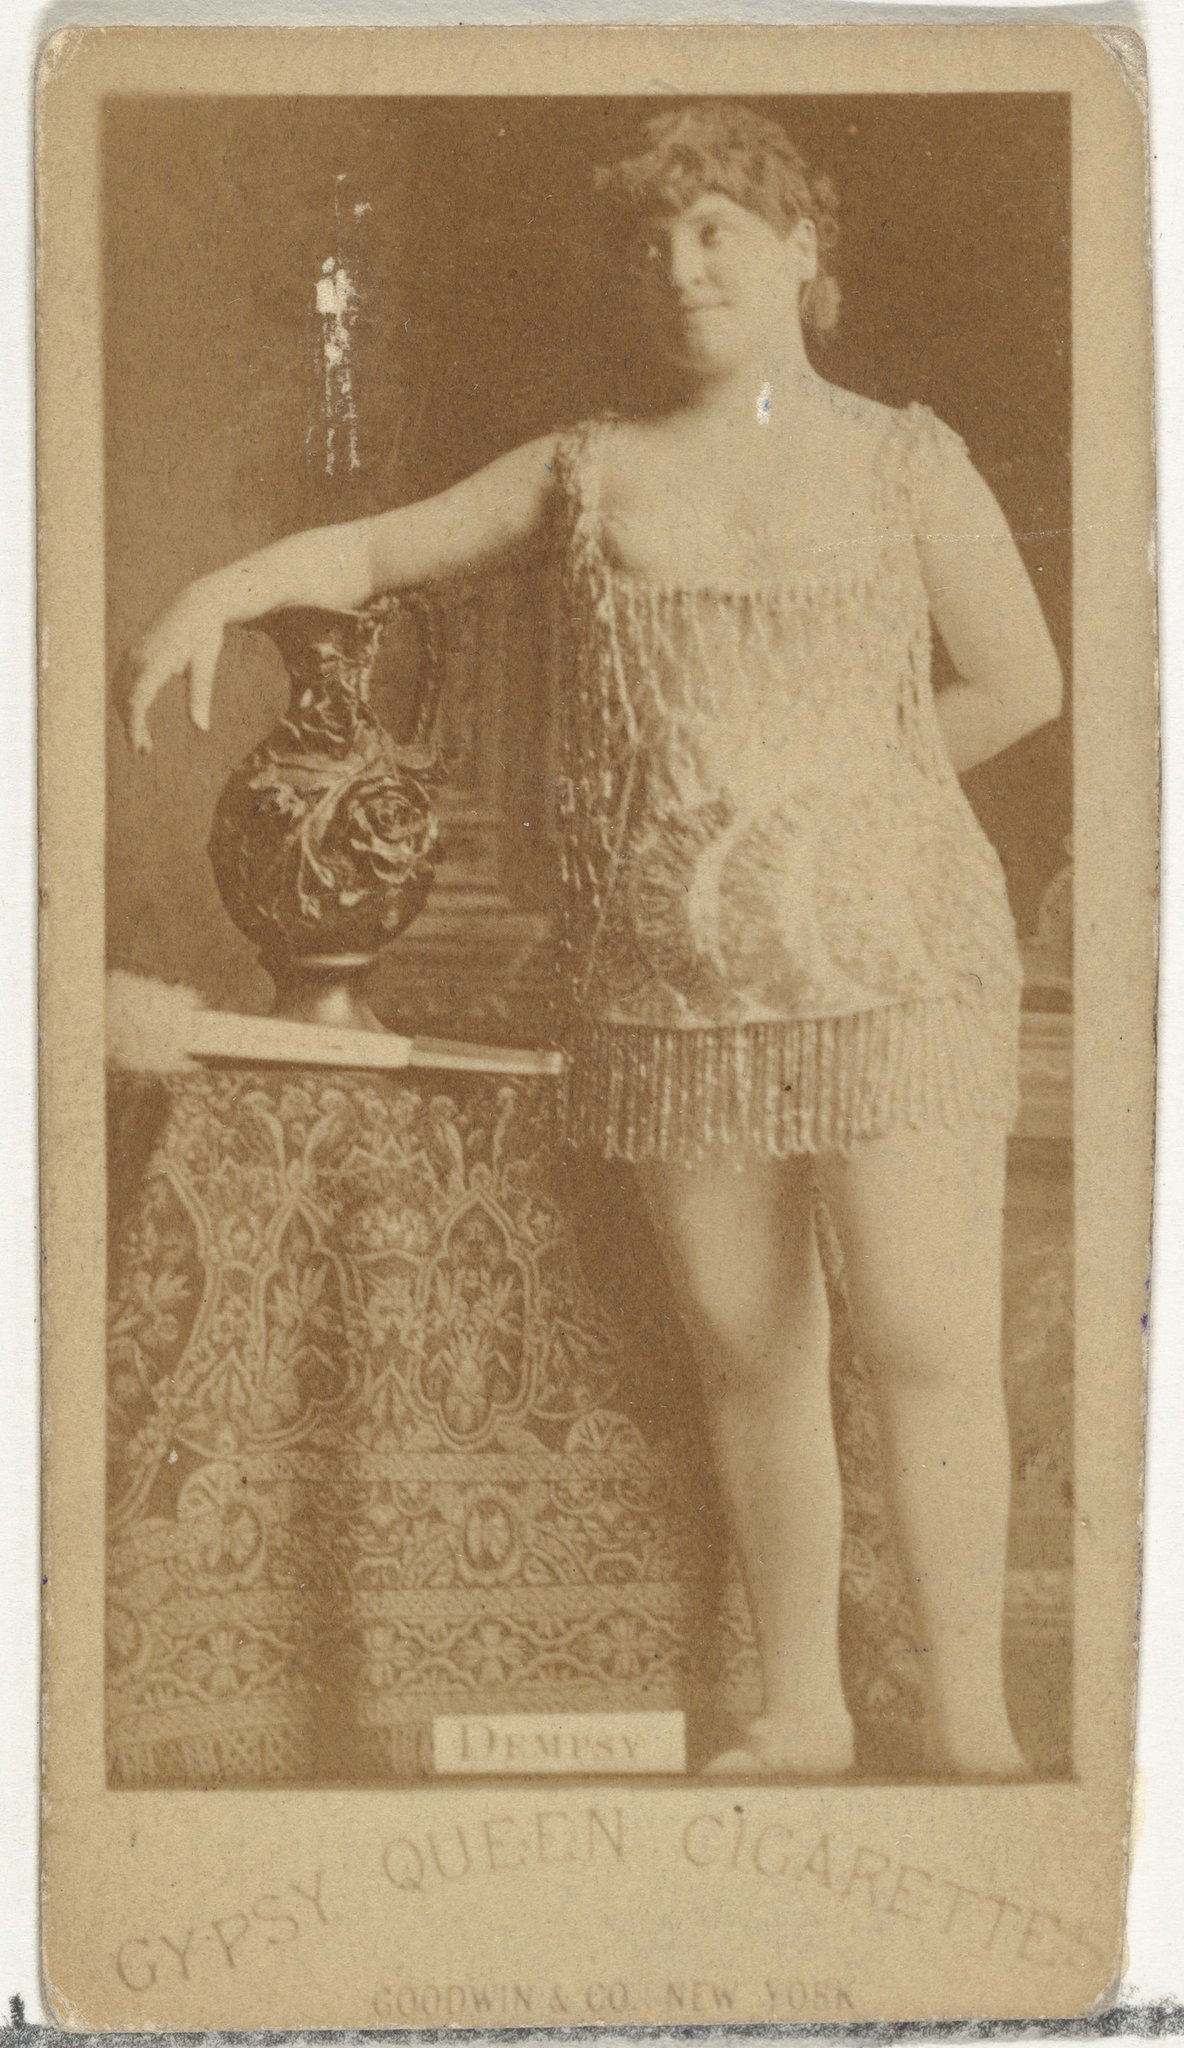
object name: photograph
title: Dempsy, from the Actors and Actresses series (N171) for Gypsy Queen Cigarettes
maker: goodwin & company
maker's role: publisher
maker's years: 1850-1950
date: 1886-1890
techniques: albumen silver print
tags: portraits,women,actresses